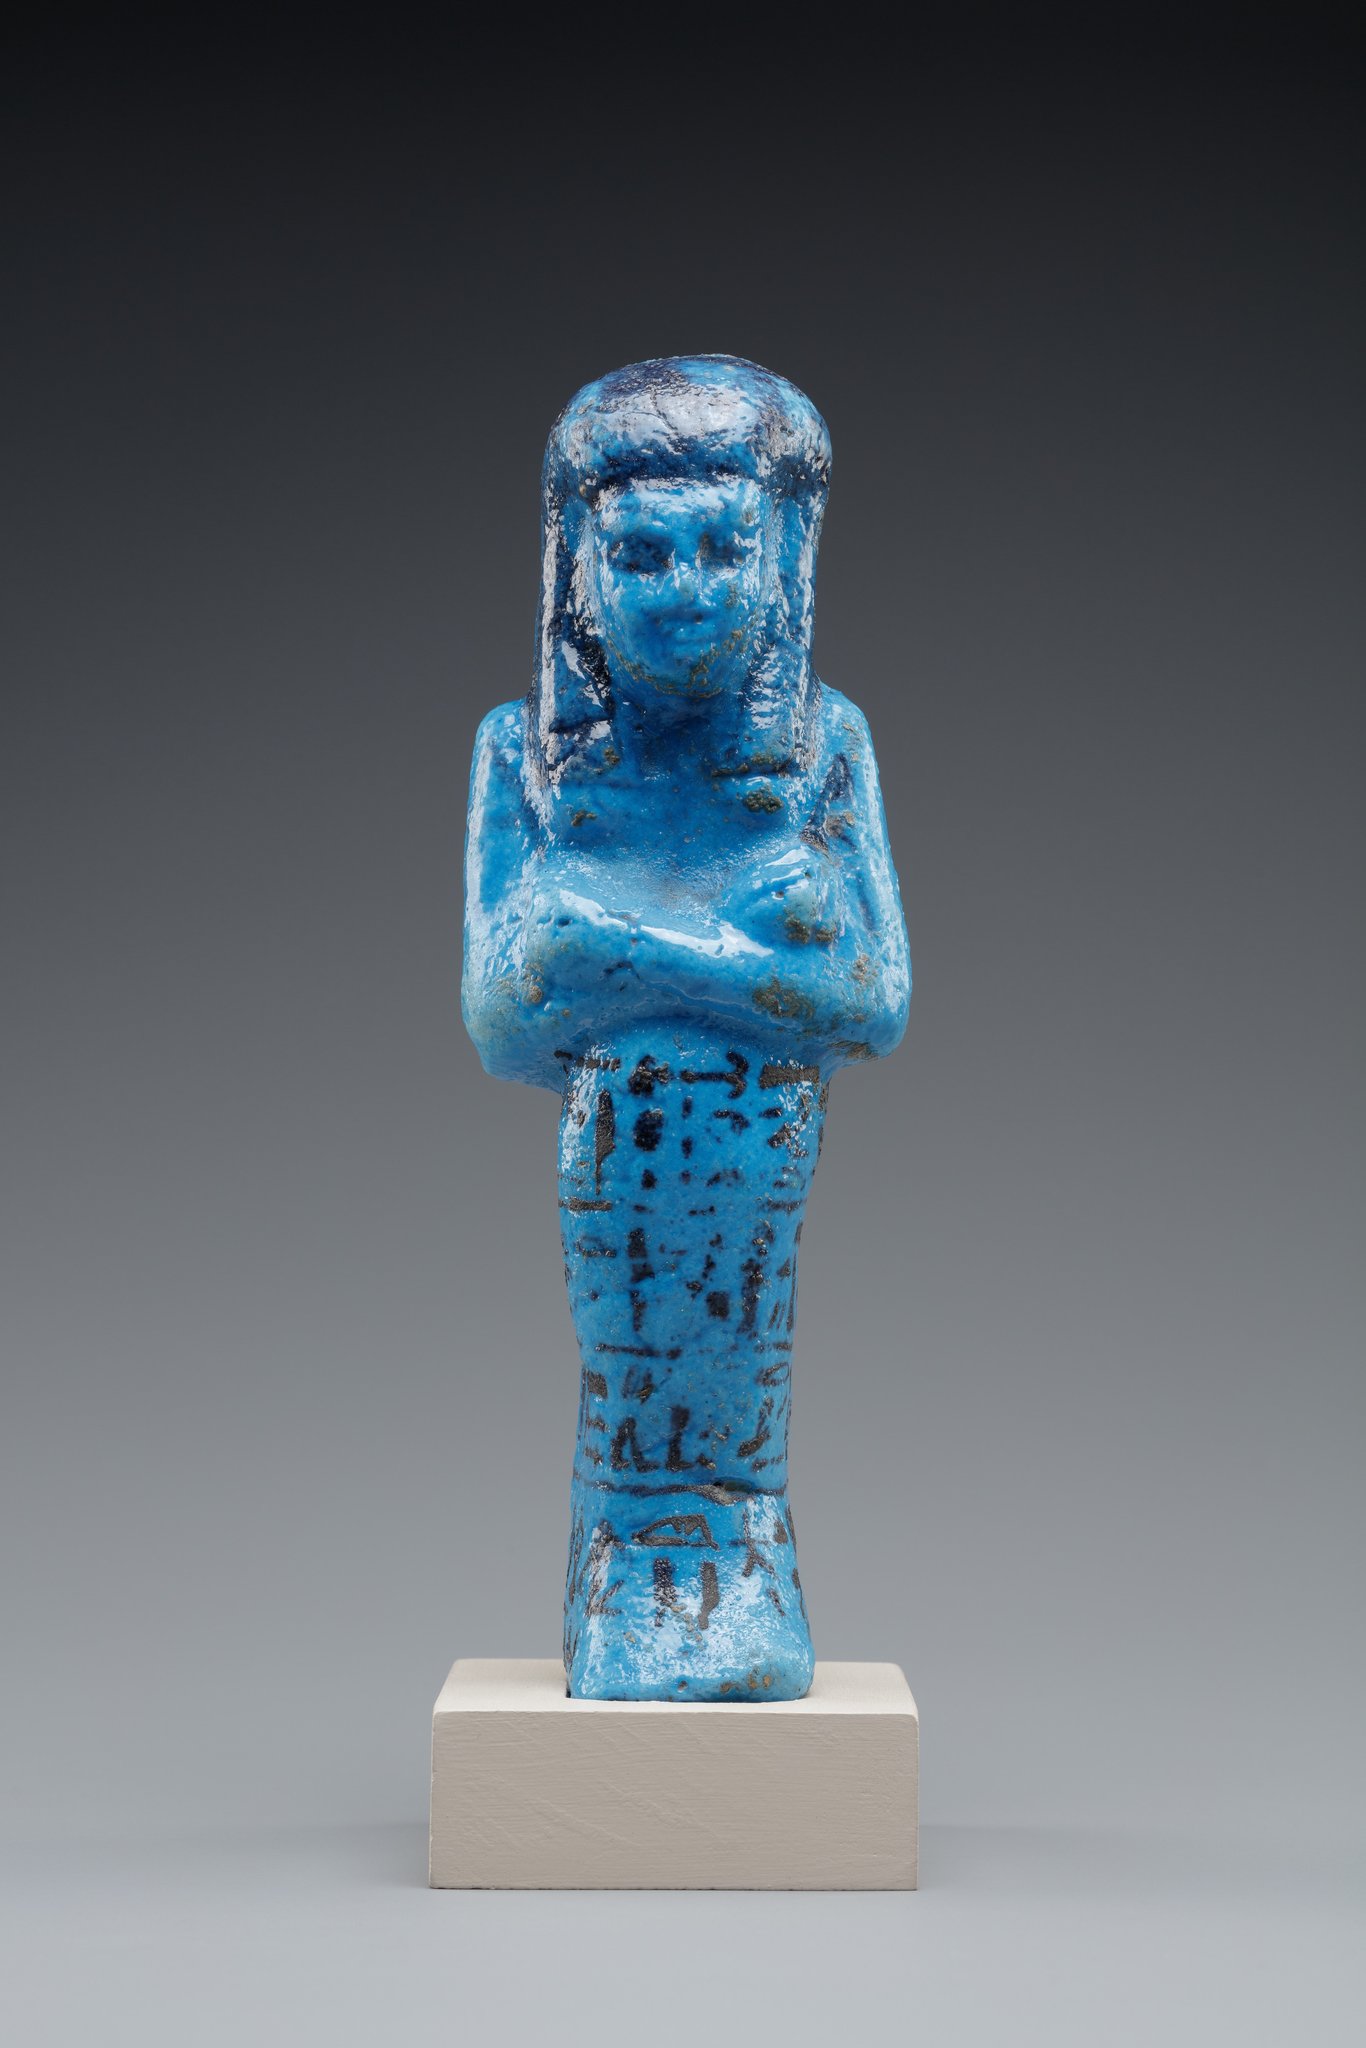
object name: shabti, princess isetemkheb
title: Shabti of Isetemkheb (D), wife of Painedjem II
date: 988-966 BCE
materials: faience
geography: egypt